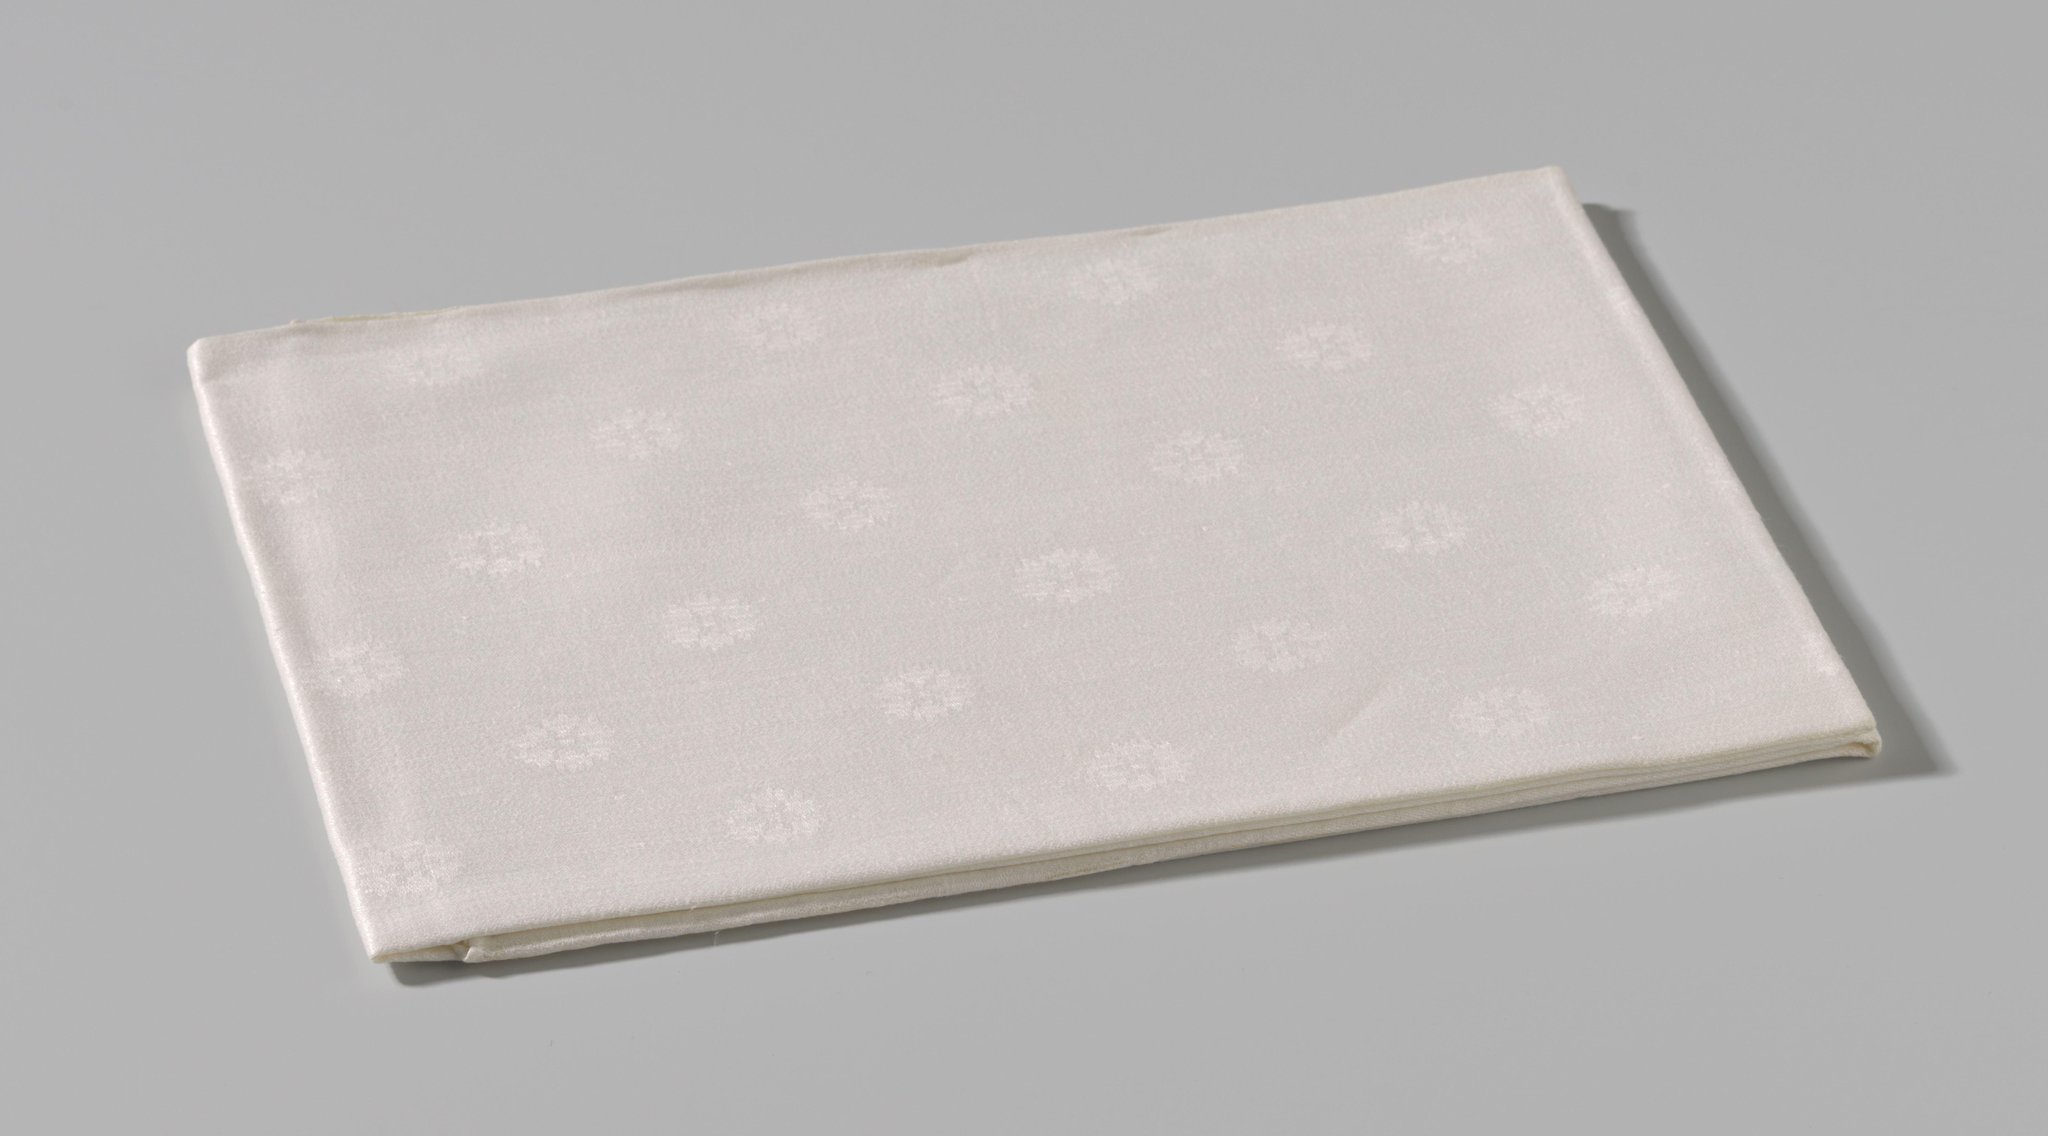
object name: napkin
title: Servet met een bloempatroon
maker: Anonymous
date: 1800-1810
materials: linen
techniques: damask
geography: western europe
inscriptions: mark: ‘ME’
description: Servet van linnendamast met een bloempatroon. Verspringende rijen van rozetten. Brede rand van spiraalsgewijs een middenstam omvattende tweezijdig gevederde bladranken. Vallend blaadje als vulling. Gelijke binnen- en buitenzoom van aaneengeschakelde cirkels. Rondom: blokkenrand. De bladranken van de servetten zijn niet identiek aan die van het tafellaken.